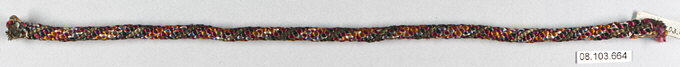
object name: cord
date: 1701-1900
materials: metal thread, silk